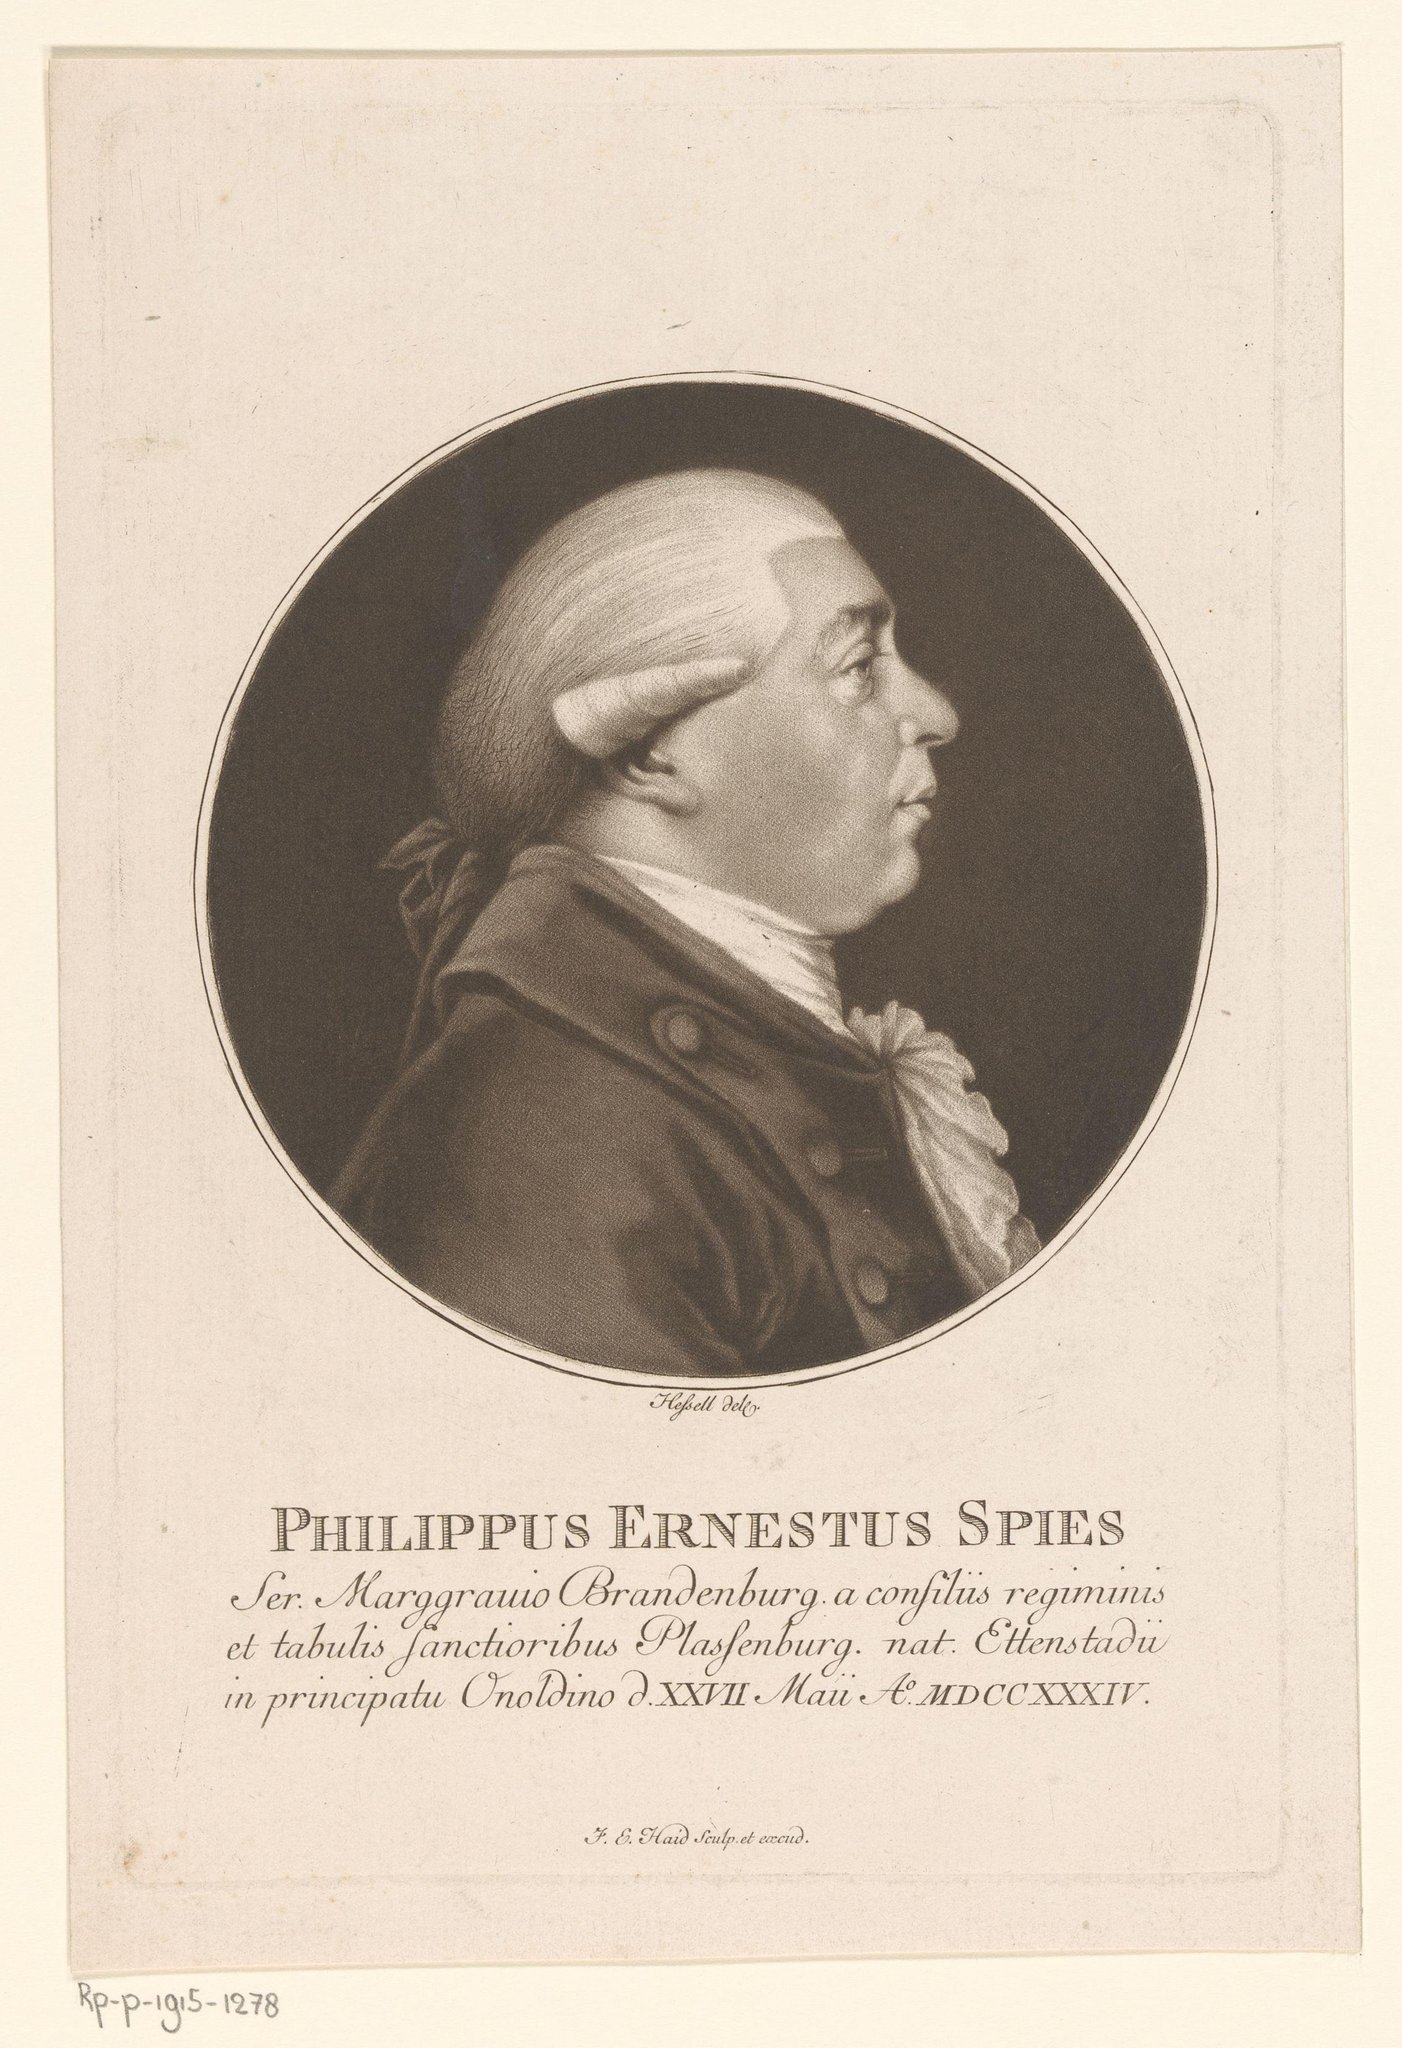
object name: print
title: Portret van Philipp Ernst Spiess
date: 1749-1794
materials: paper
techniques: etching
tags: historical persons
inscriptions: collector's mark: Lugt 2228